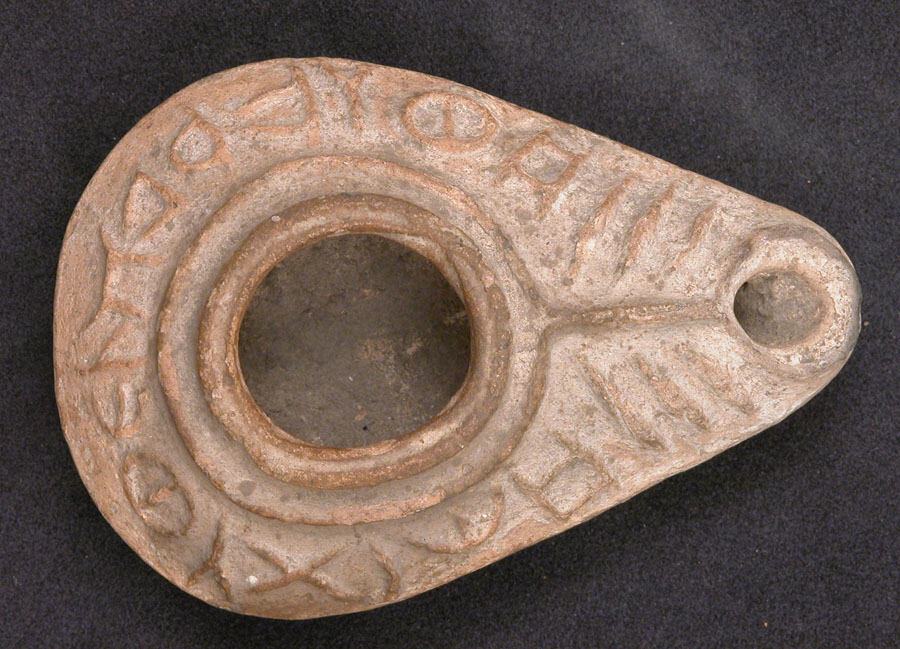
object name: lamp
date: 301-600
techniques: molding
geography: egypt